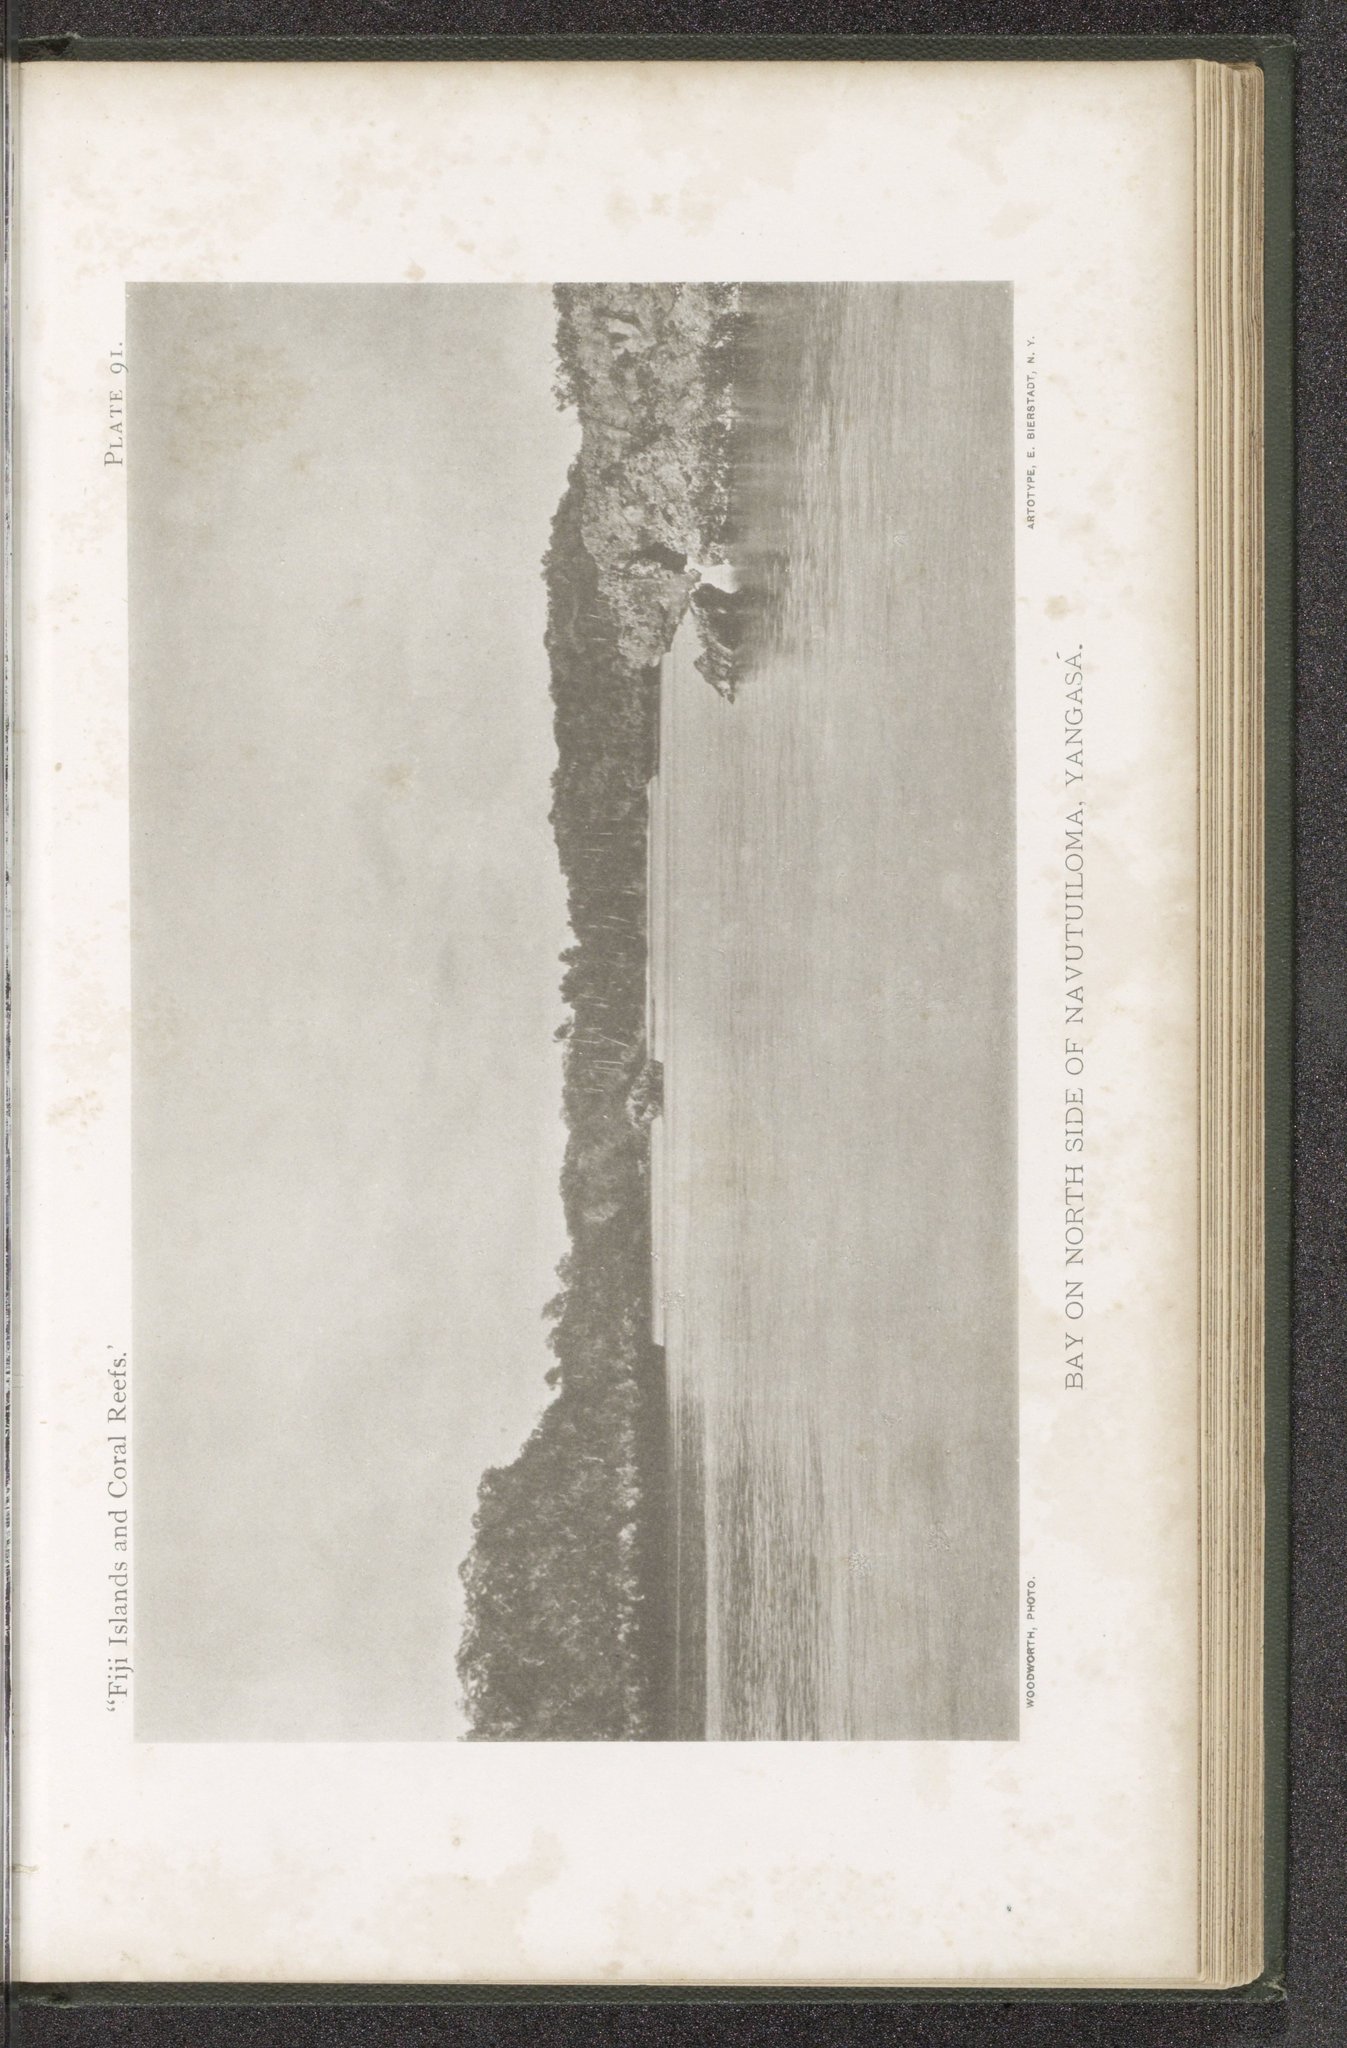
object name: page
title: Bay on north side of Navutuiloma, Yangasá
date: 1885-1899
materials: paper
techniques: photograph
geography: fiji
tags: gulf, bay, island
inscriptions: name: ‘Artotype, E. Bierstadt, N. Y.’, name: ‘Woodworth, Photo.’, number: ‘Plate 91.’